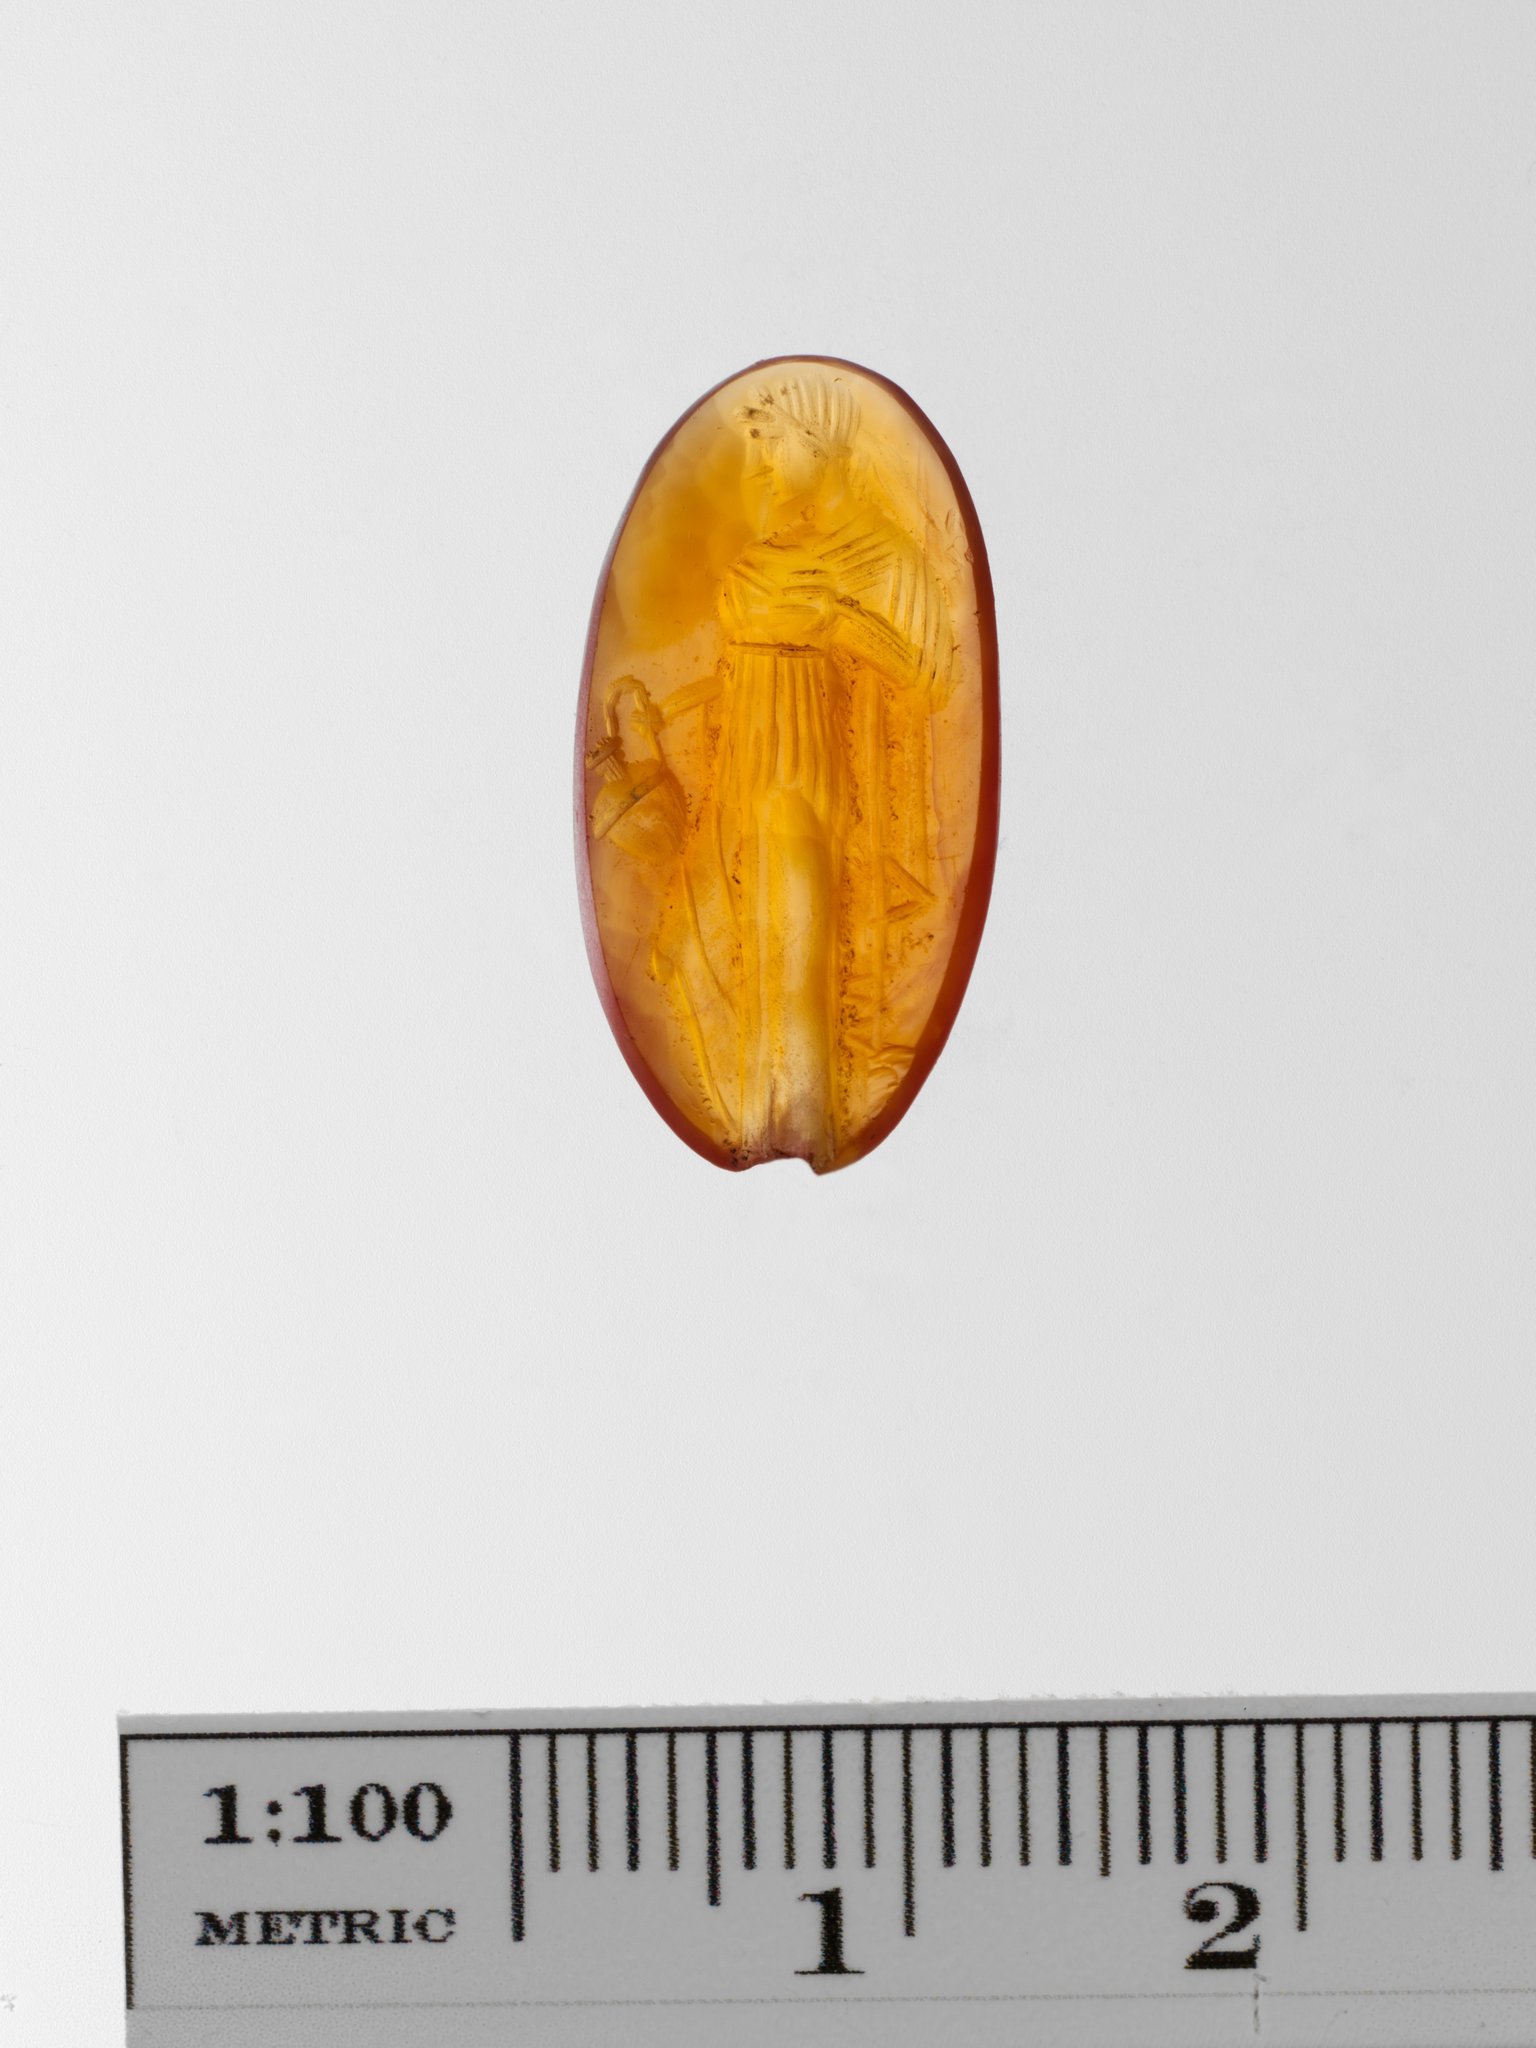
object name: intaglio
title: Sard ring stone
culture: greek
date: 300-201 BCE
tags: girls